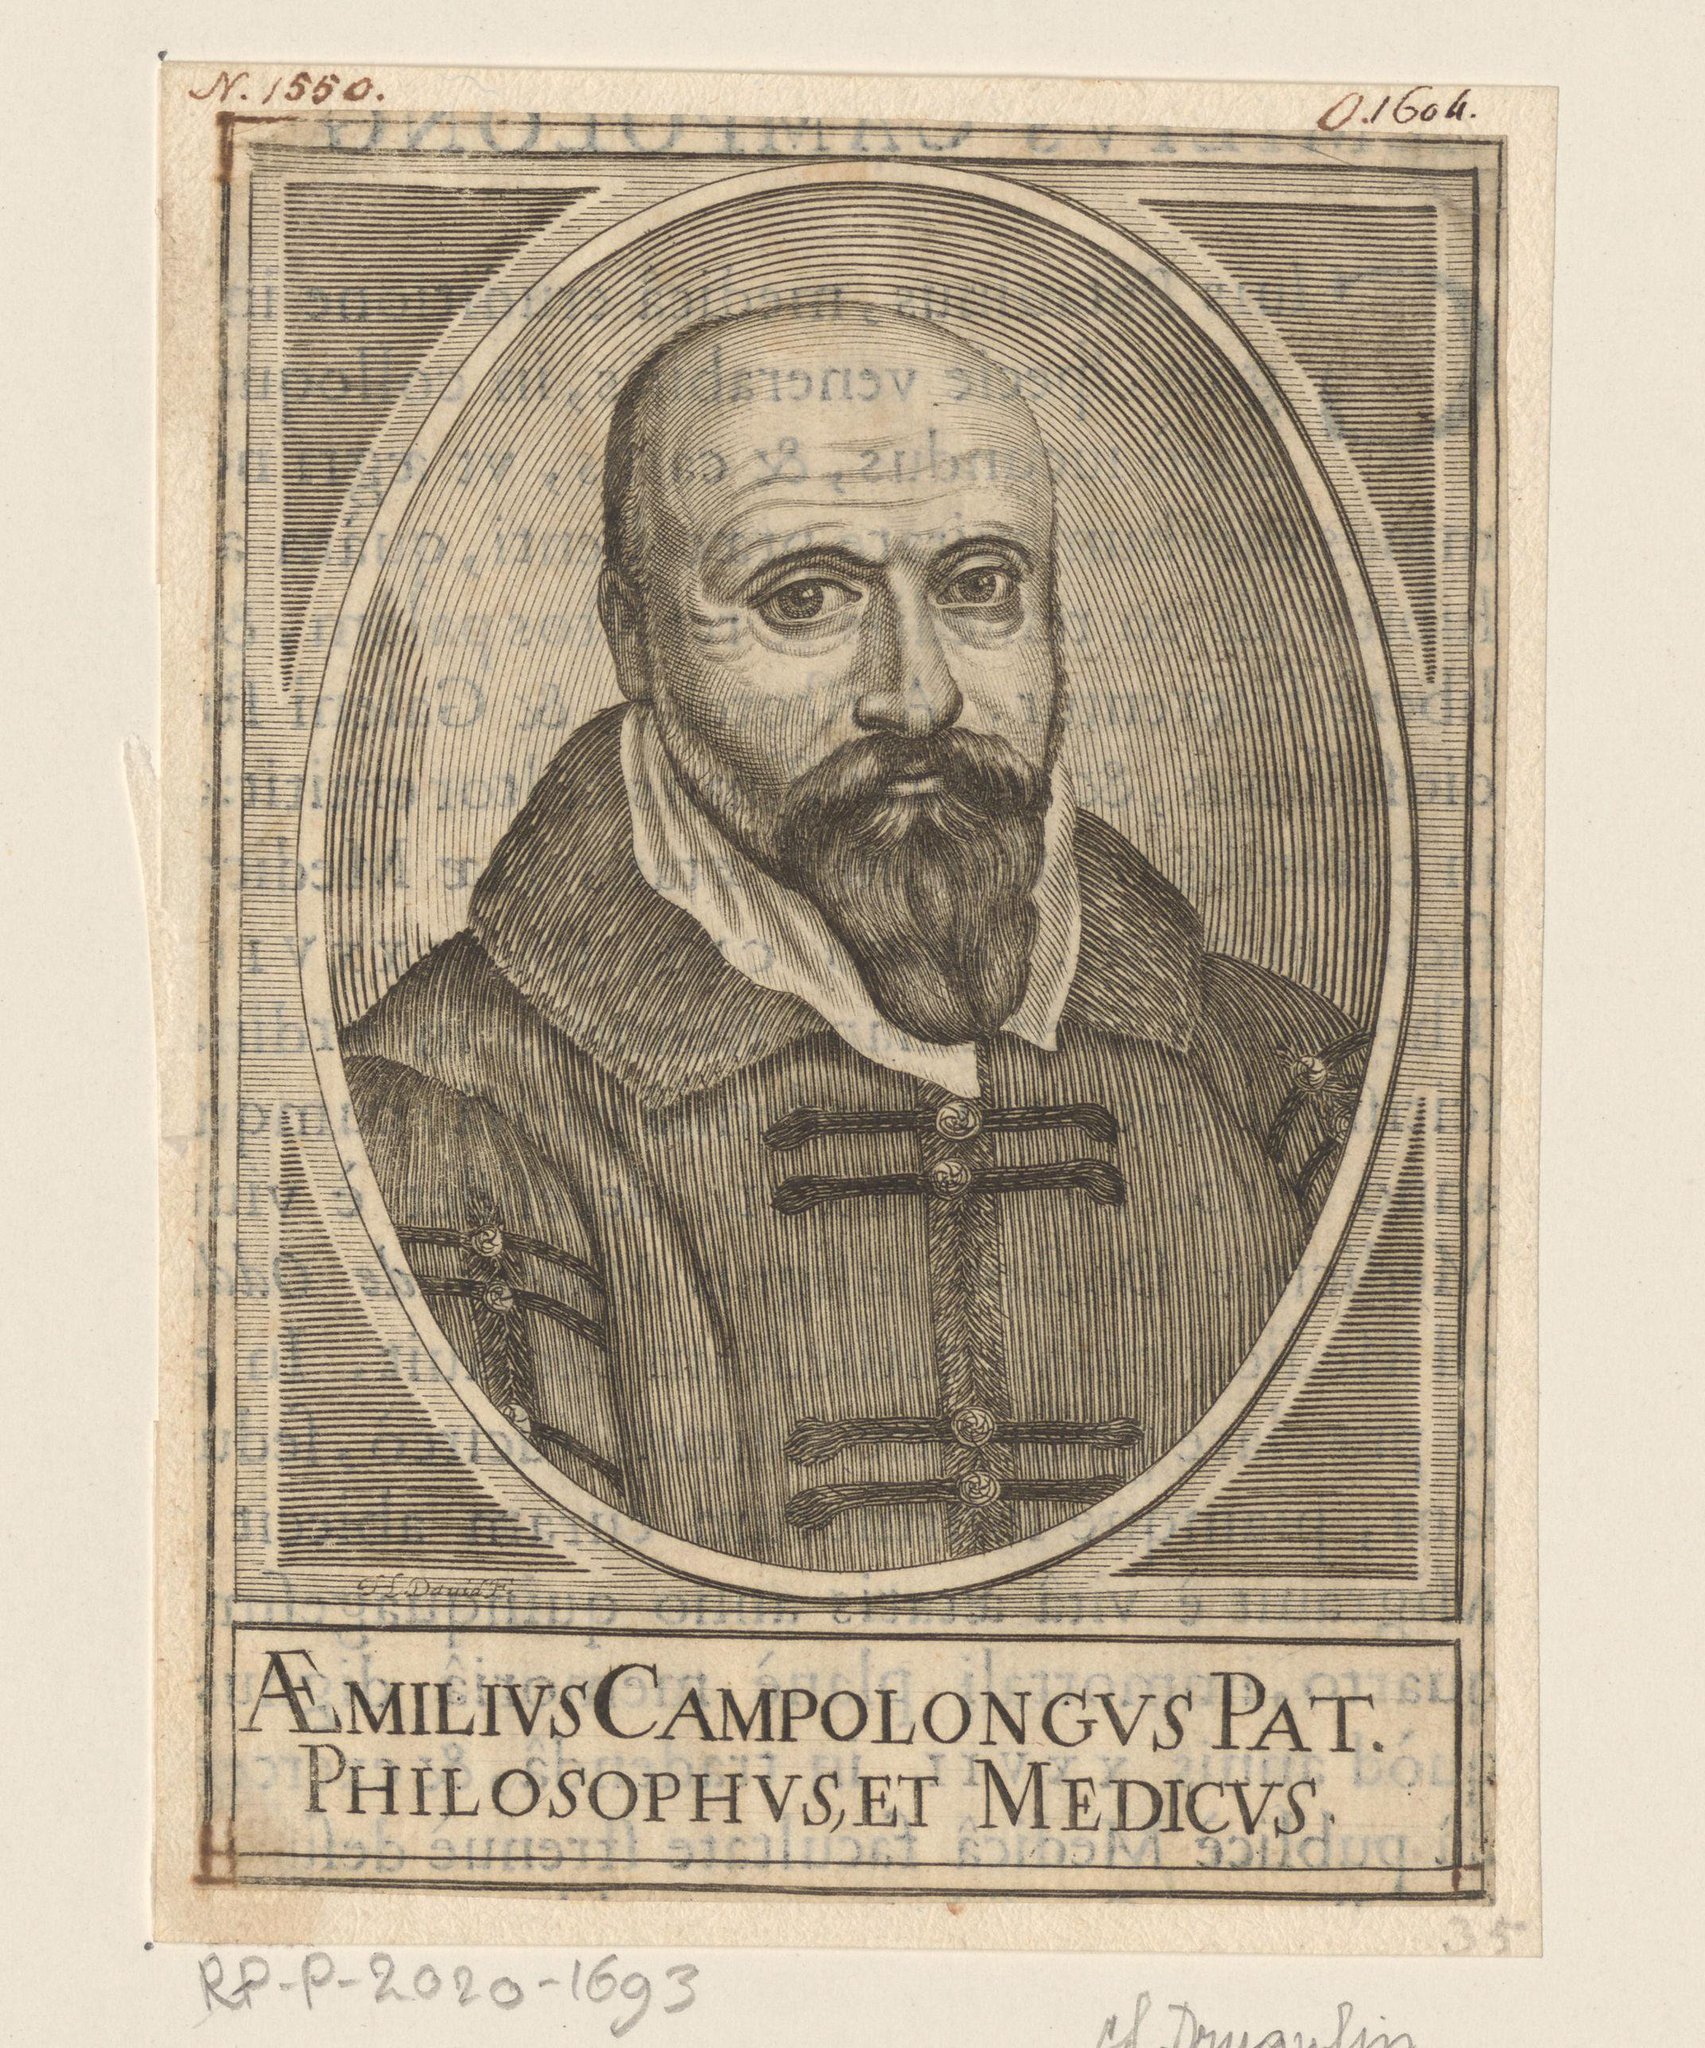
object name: print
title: Portret van Emilio Campolongo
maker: Anonymous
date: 1630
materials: paper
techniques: engraving, letterpress printing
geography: padua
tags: historical persons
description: Prent uit: Tomasini, Giacomo Filippo. Iacobi Philippi Tomasini patavini Illustrium virorum elogia, iconibus exornata. Padua: Donatum Pasquardum & Socium, 1630.